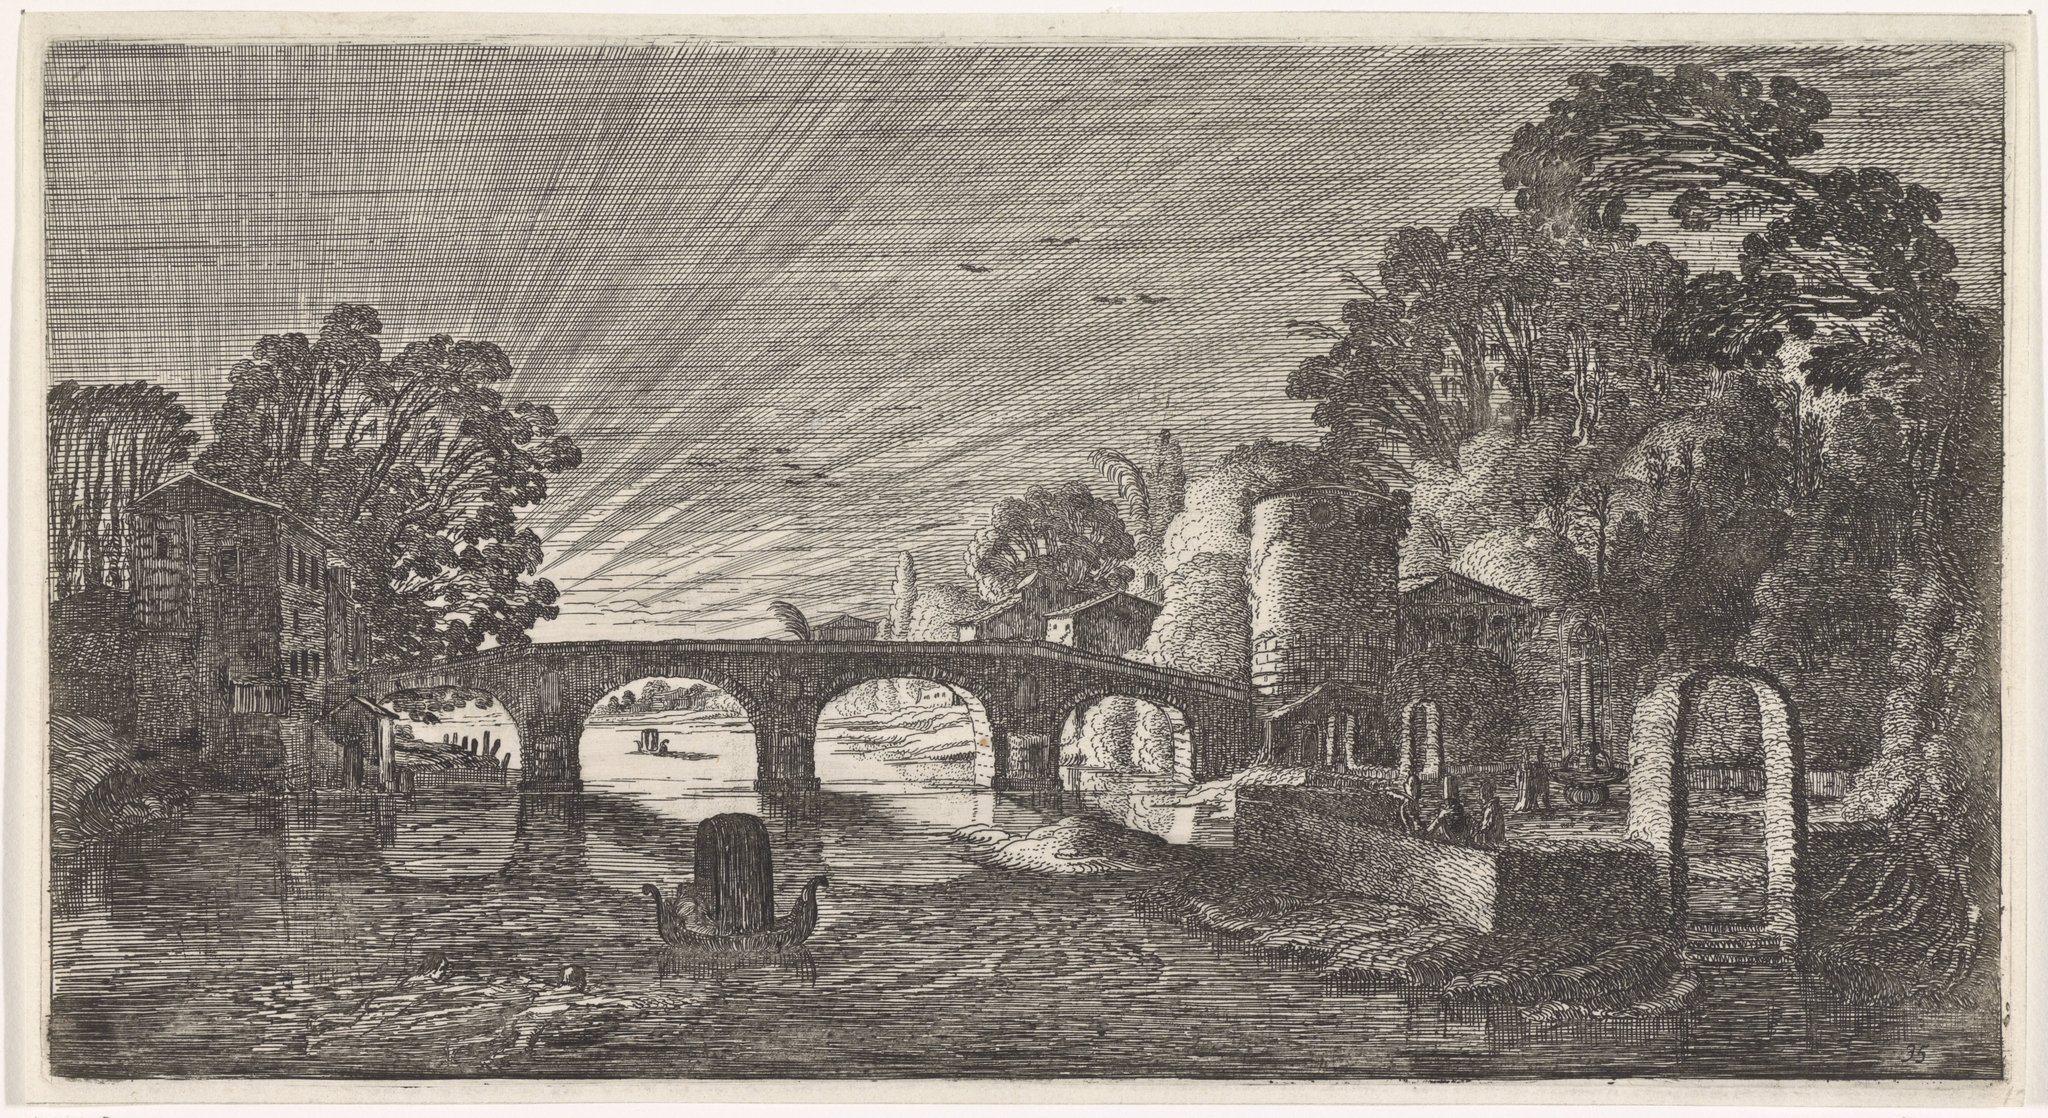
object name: print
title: Riviergezicht bij zonsondergang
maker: jan van de velde (ii)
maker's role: draughtsman, painter, print maker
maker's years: 1593-1641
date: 1639-1641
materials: paper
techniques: engraving, etching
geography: northern netherlands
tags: dusk, evening twilight, river, landscape with bridge, viaduct or aqueduct, sunset, bridge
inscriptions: collector's mark: Lugt 964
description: Riviergezicht bij zondondergang. In het midden een stenen brug. Links twee zwemmende figuren en rechts converserende figuren in een tuin. 35ste prent van een serie met 36 prenten van landschappen, verdeeld over zes delen.